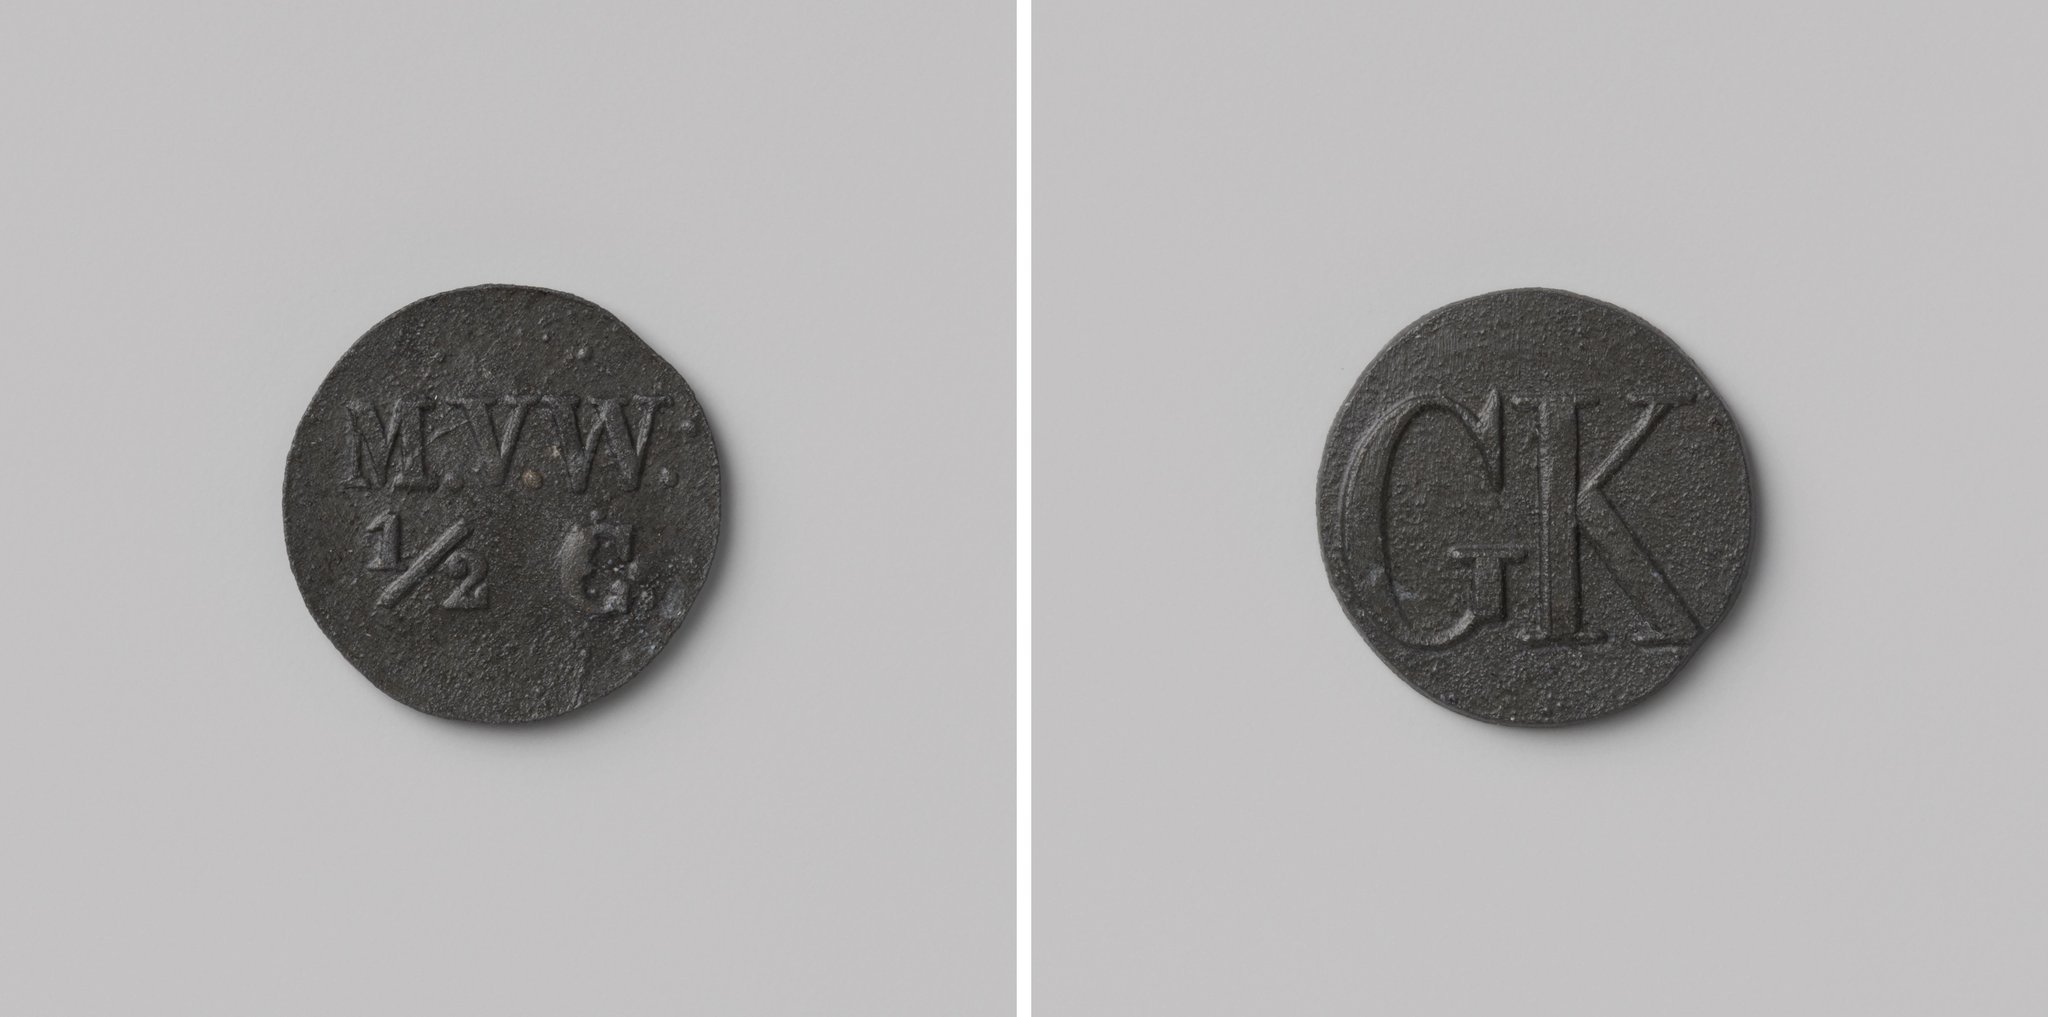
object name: monetary token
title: Huismunt geslagen op last van de Maatschappij van Weldadigheid ter waarde van ½ cent, ten behoeve van de Gewone Koloniën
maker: Anonymous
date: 1818-1859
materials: zinc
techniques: striking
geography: netherlands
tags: maatschappij van weldadigheid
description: Zinken munt. Voorzijde: opschrift boven waardeaanduiding. Keerzijde: opschrift G en K